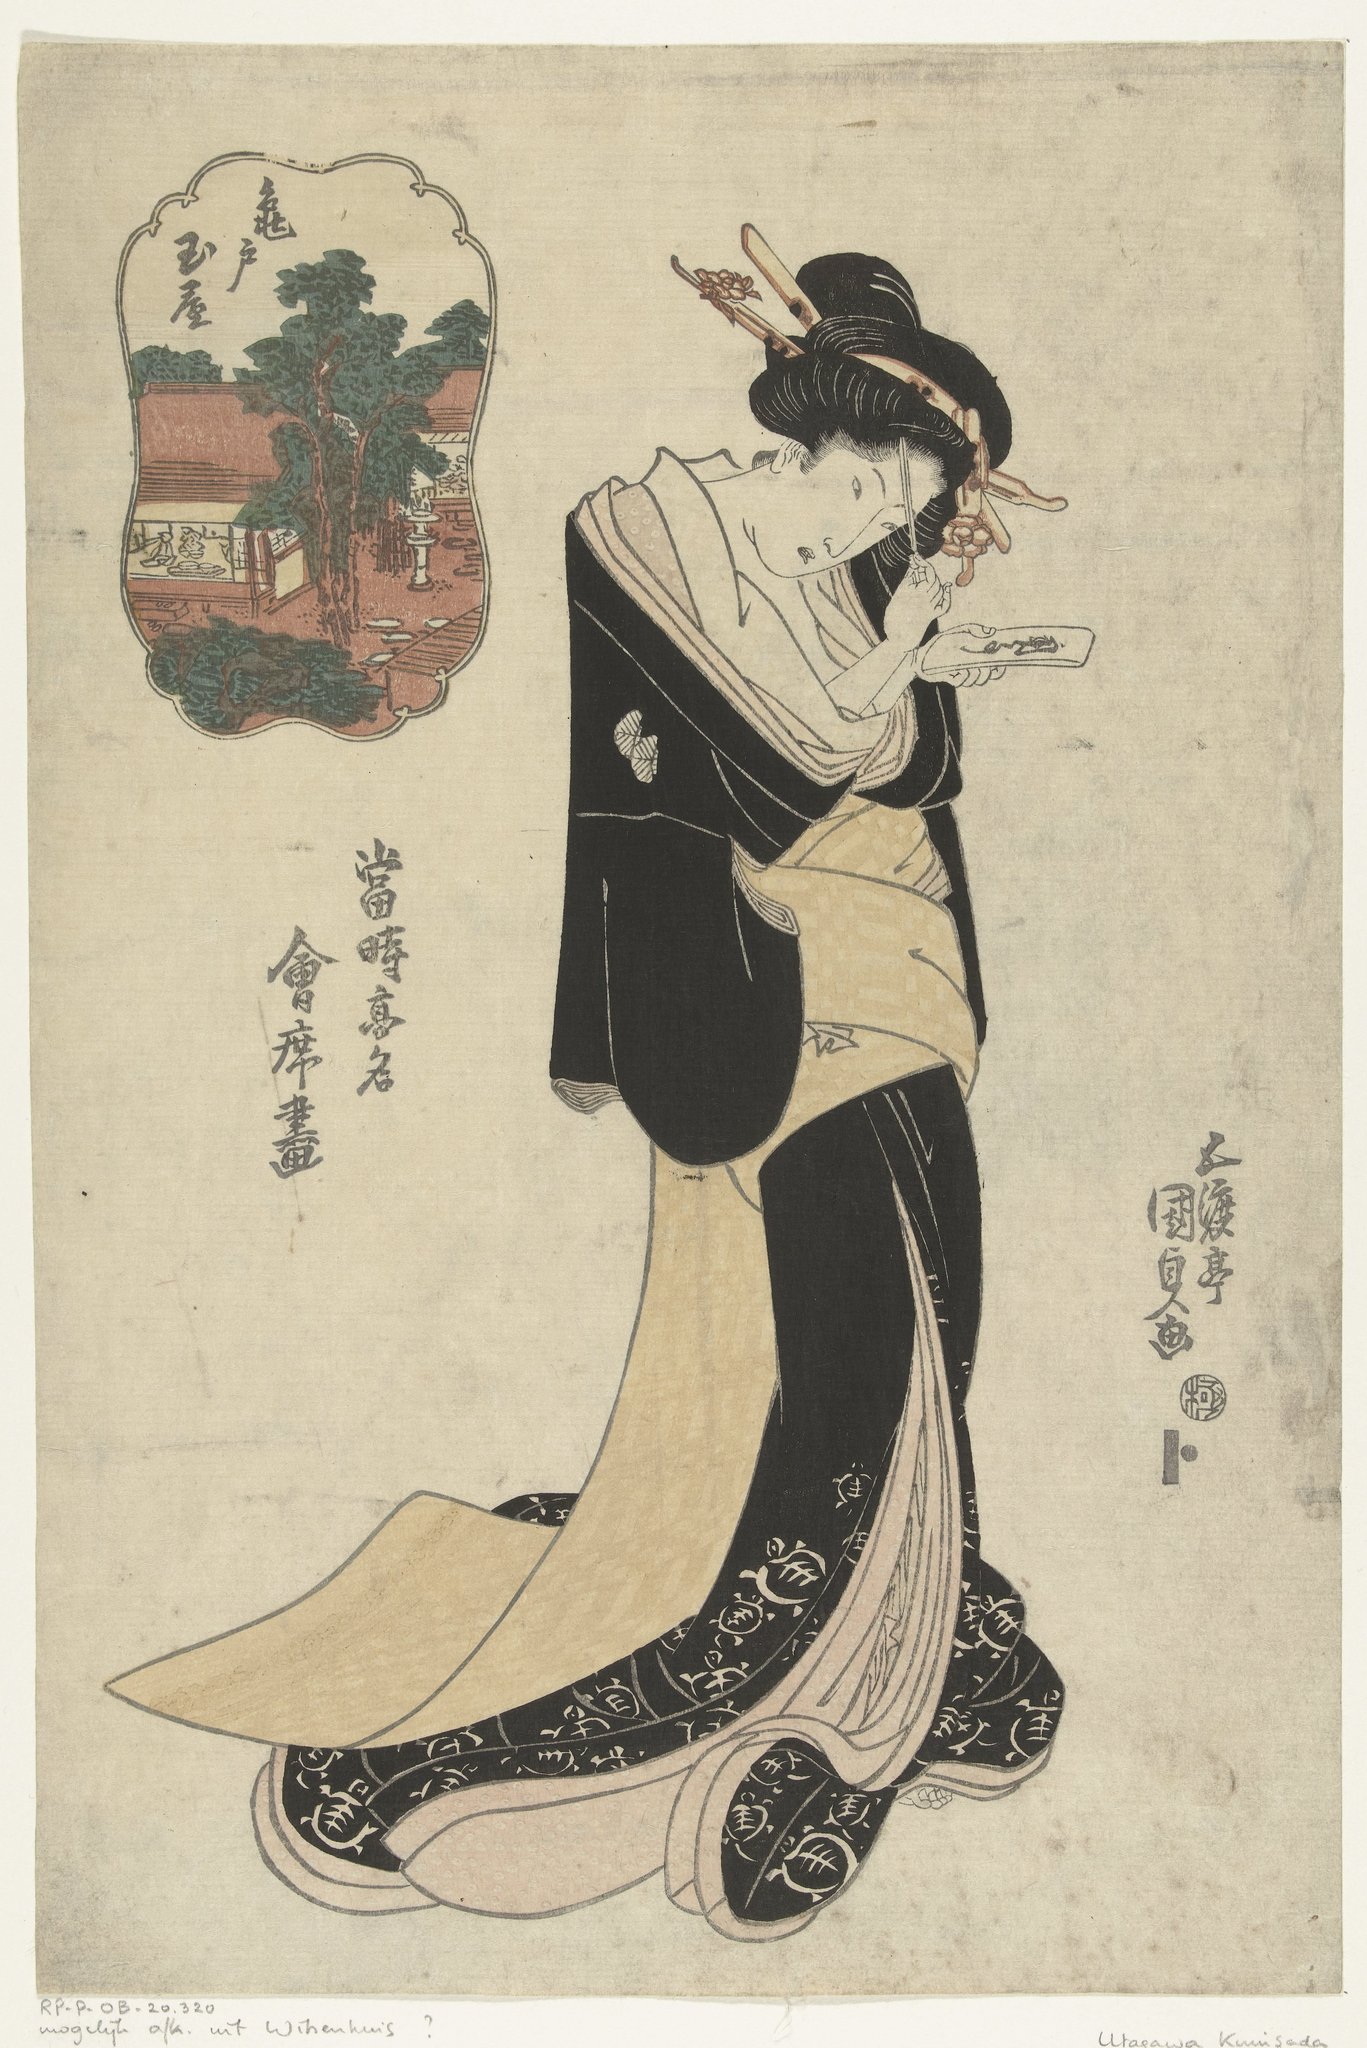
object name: print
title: Afbeeldingen van hedendaagse gerenommeerde restaurants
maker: utagawa kunisada (i)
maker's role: print maker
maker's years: 1786-1865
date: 1820-1825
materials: paper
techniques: woodcut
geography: japan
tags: inn, coffee-house, public house, etc., standing figure - aa - female human figure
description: Courtisane, ten voeten uit, met brief in linker en haarpin in rechter hand; linksboven een cartouche met gezicht op restaurant in tuin.